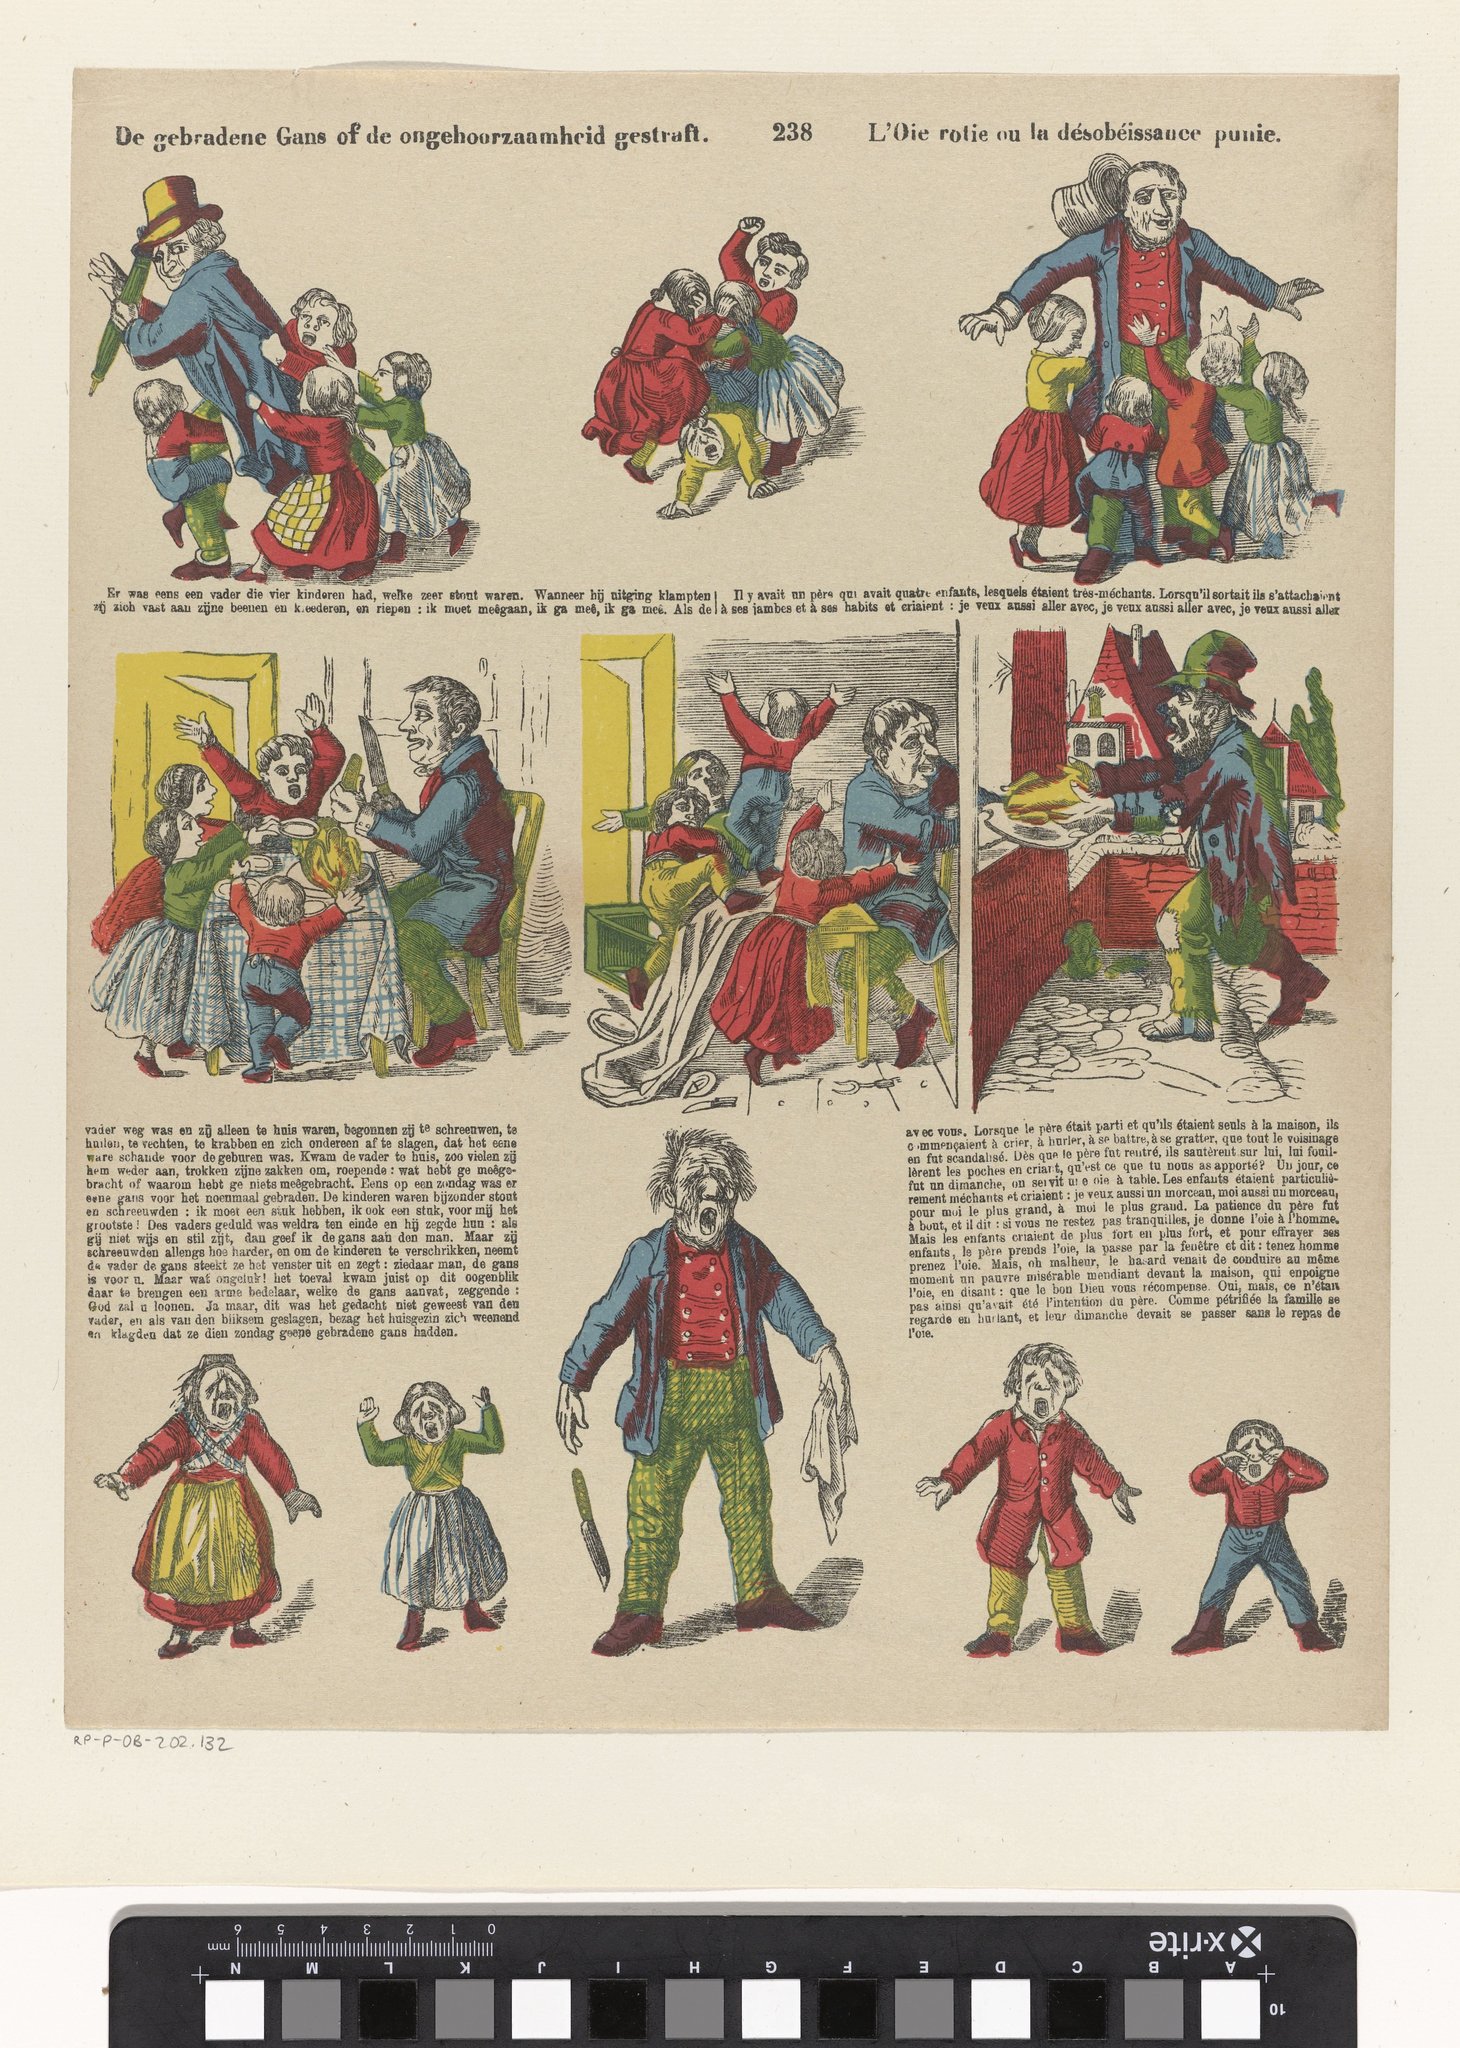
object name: print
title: De gebradene gans of de ongehoorzaamheid gestraft / L'Oie rôtie ou la désobéissance punie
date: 1833-1911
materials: paper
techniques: lithograph, letterpress printing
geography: turnhout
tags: hunger, water-birds: goose, father and child(ren), man and child(ren) (family group)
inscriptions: collector's mark: Lugt 2760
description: Blad met 11 voorstellingen uit het verhaal van de gebraden gans. Hoe verwende kinderen een vader radeloos maken en uiteindelijk geen eten hebben. Tekst tussen de afbeeldingen in het Nederlands en in het Frans. Genummerd midden boven: 238.